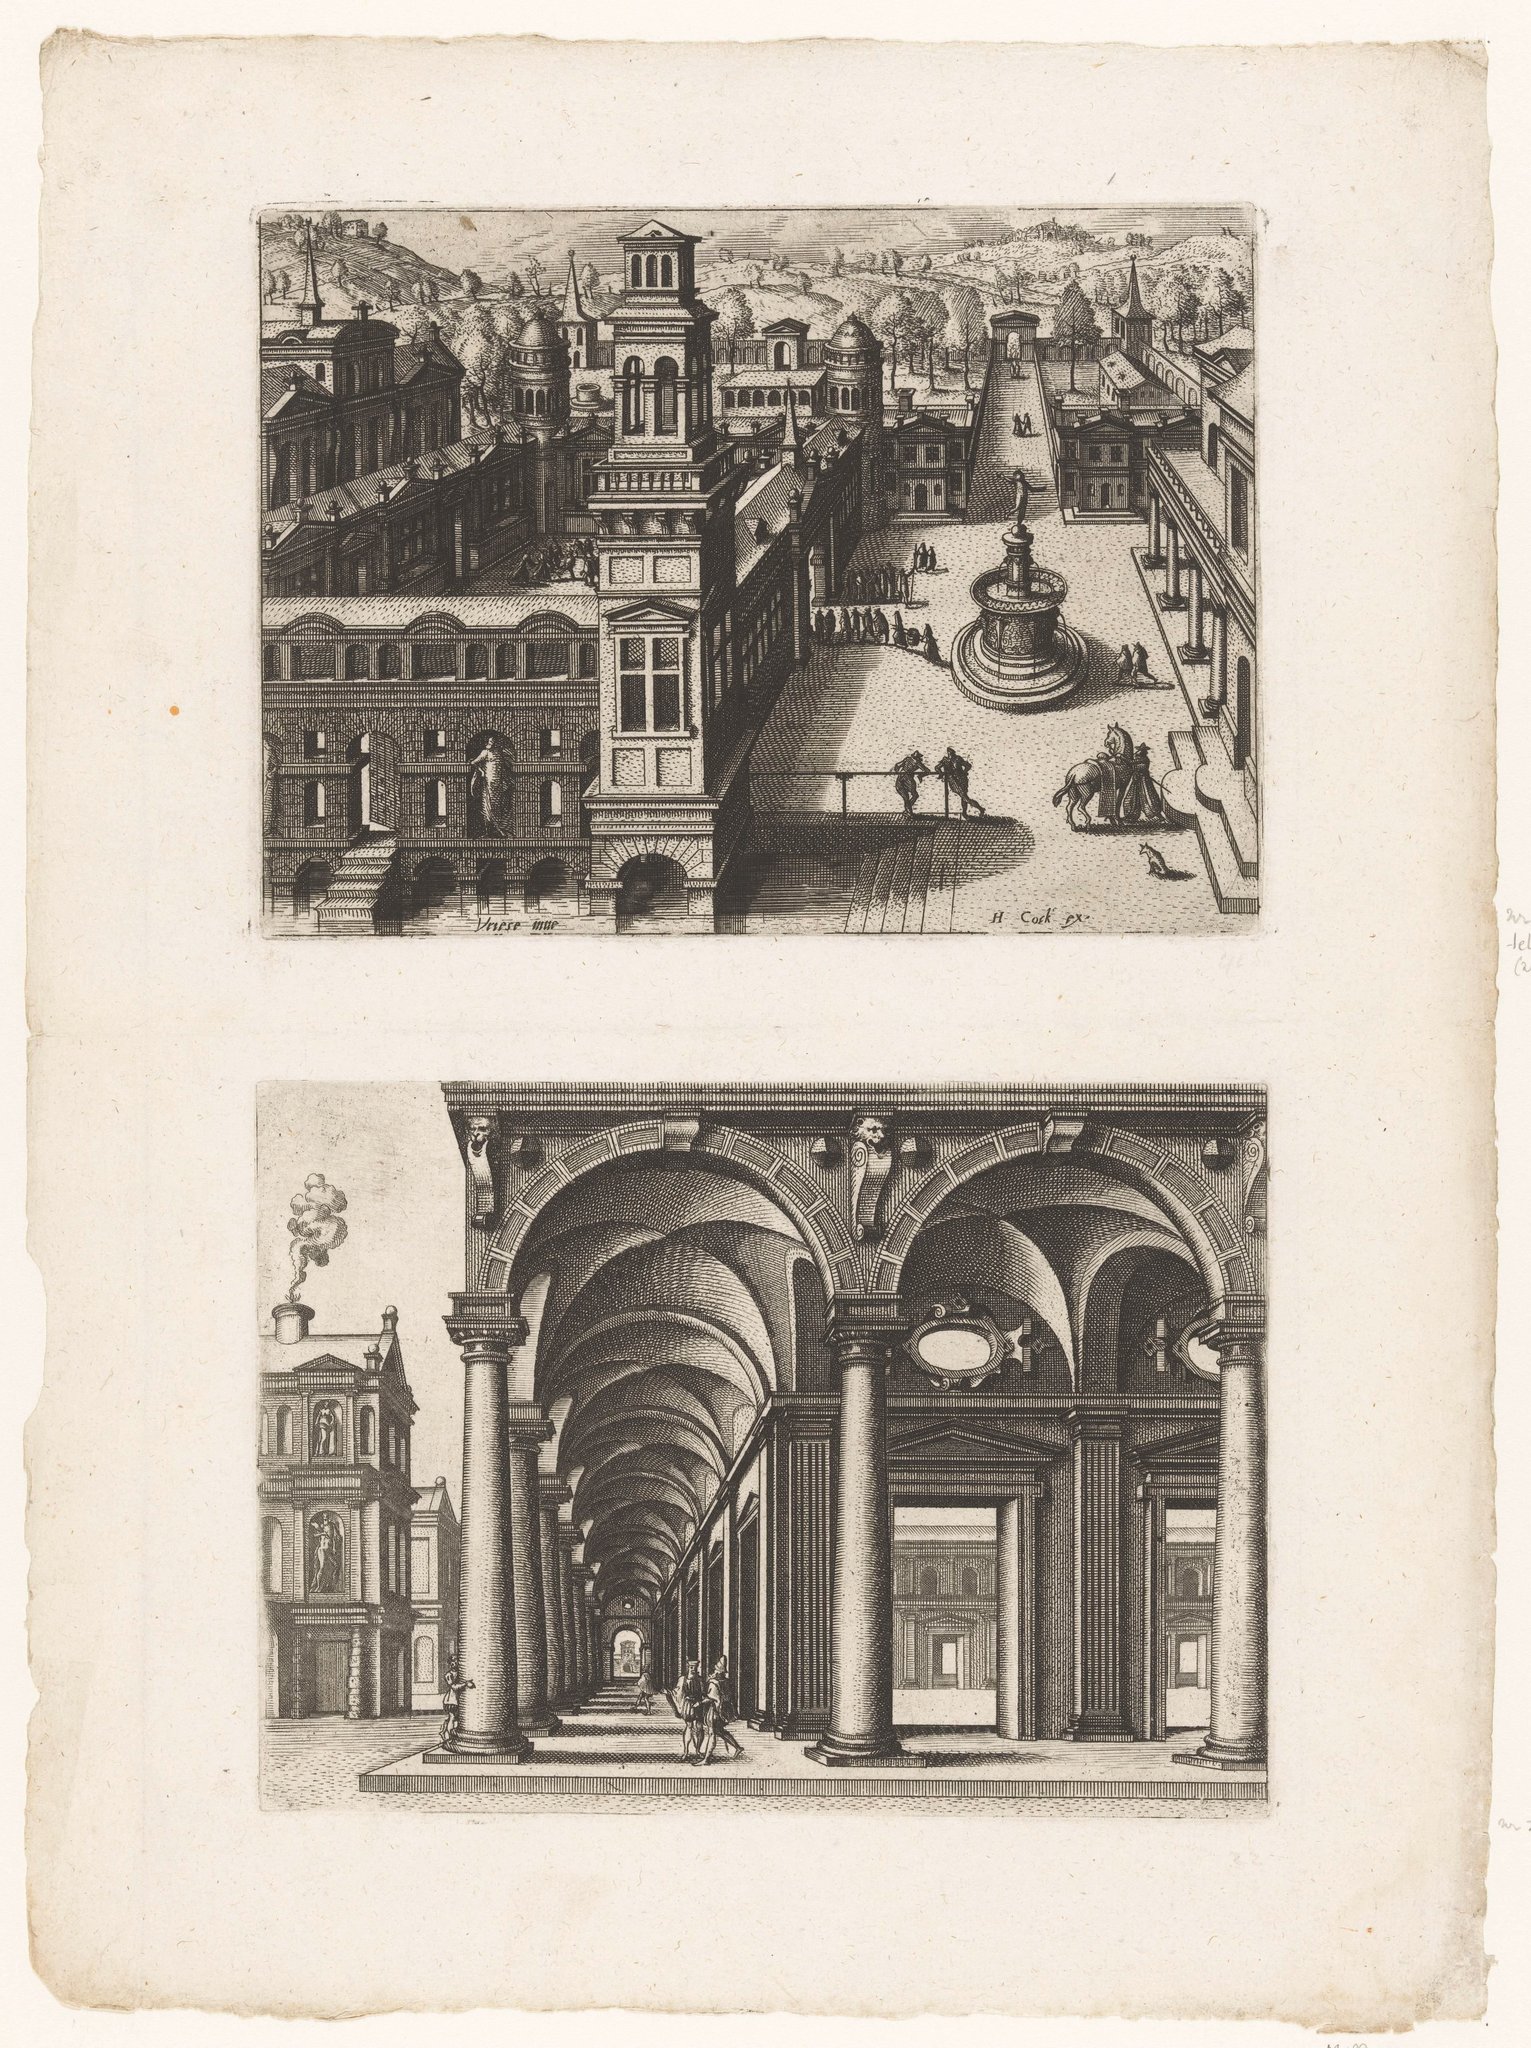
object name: print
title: Paleis met binnenplaats en colonnade rondom binnenplaats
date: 1562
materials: paper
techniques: etching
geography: southern netherlands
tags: colonnade, palace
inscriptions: collector's mark: Lugt 2228, collector's mark: Lugt 2760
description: Twee prenten op een blad. Boven: Een paleis met een binnenplaats en een voorplein met een fontein in semi-vogelvlucht. Rechts op de voorgrond staat een man met een paard. Onder: Een colonnade rond een open binnenplaats. Onder de galerij lopen drie mensen, een vierde staat links achter de hoekzuil.